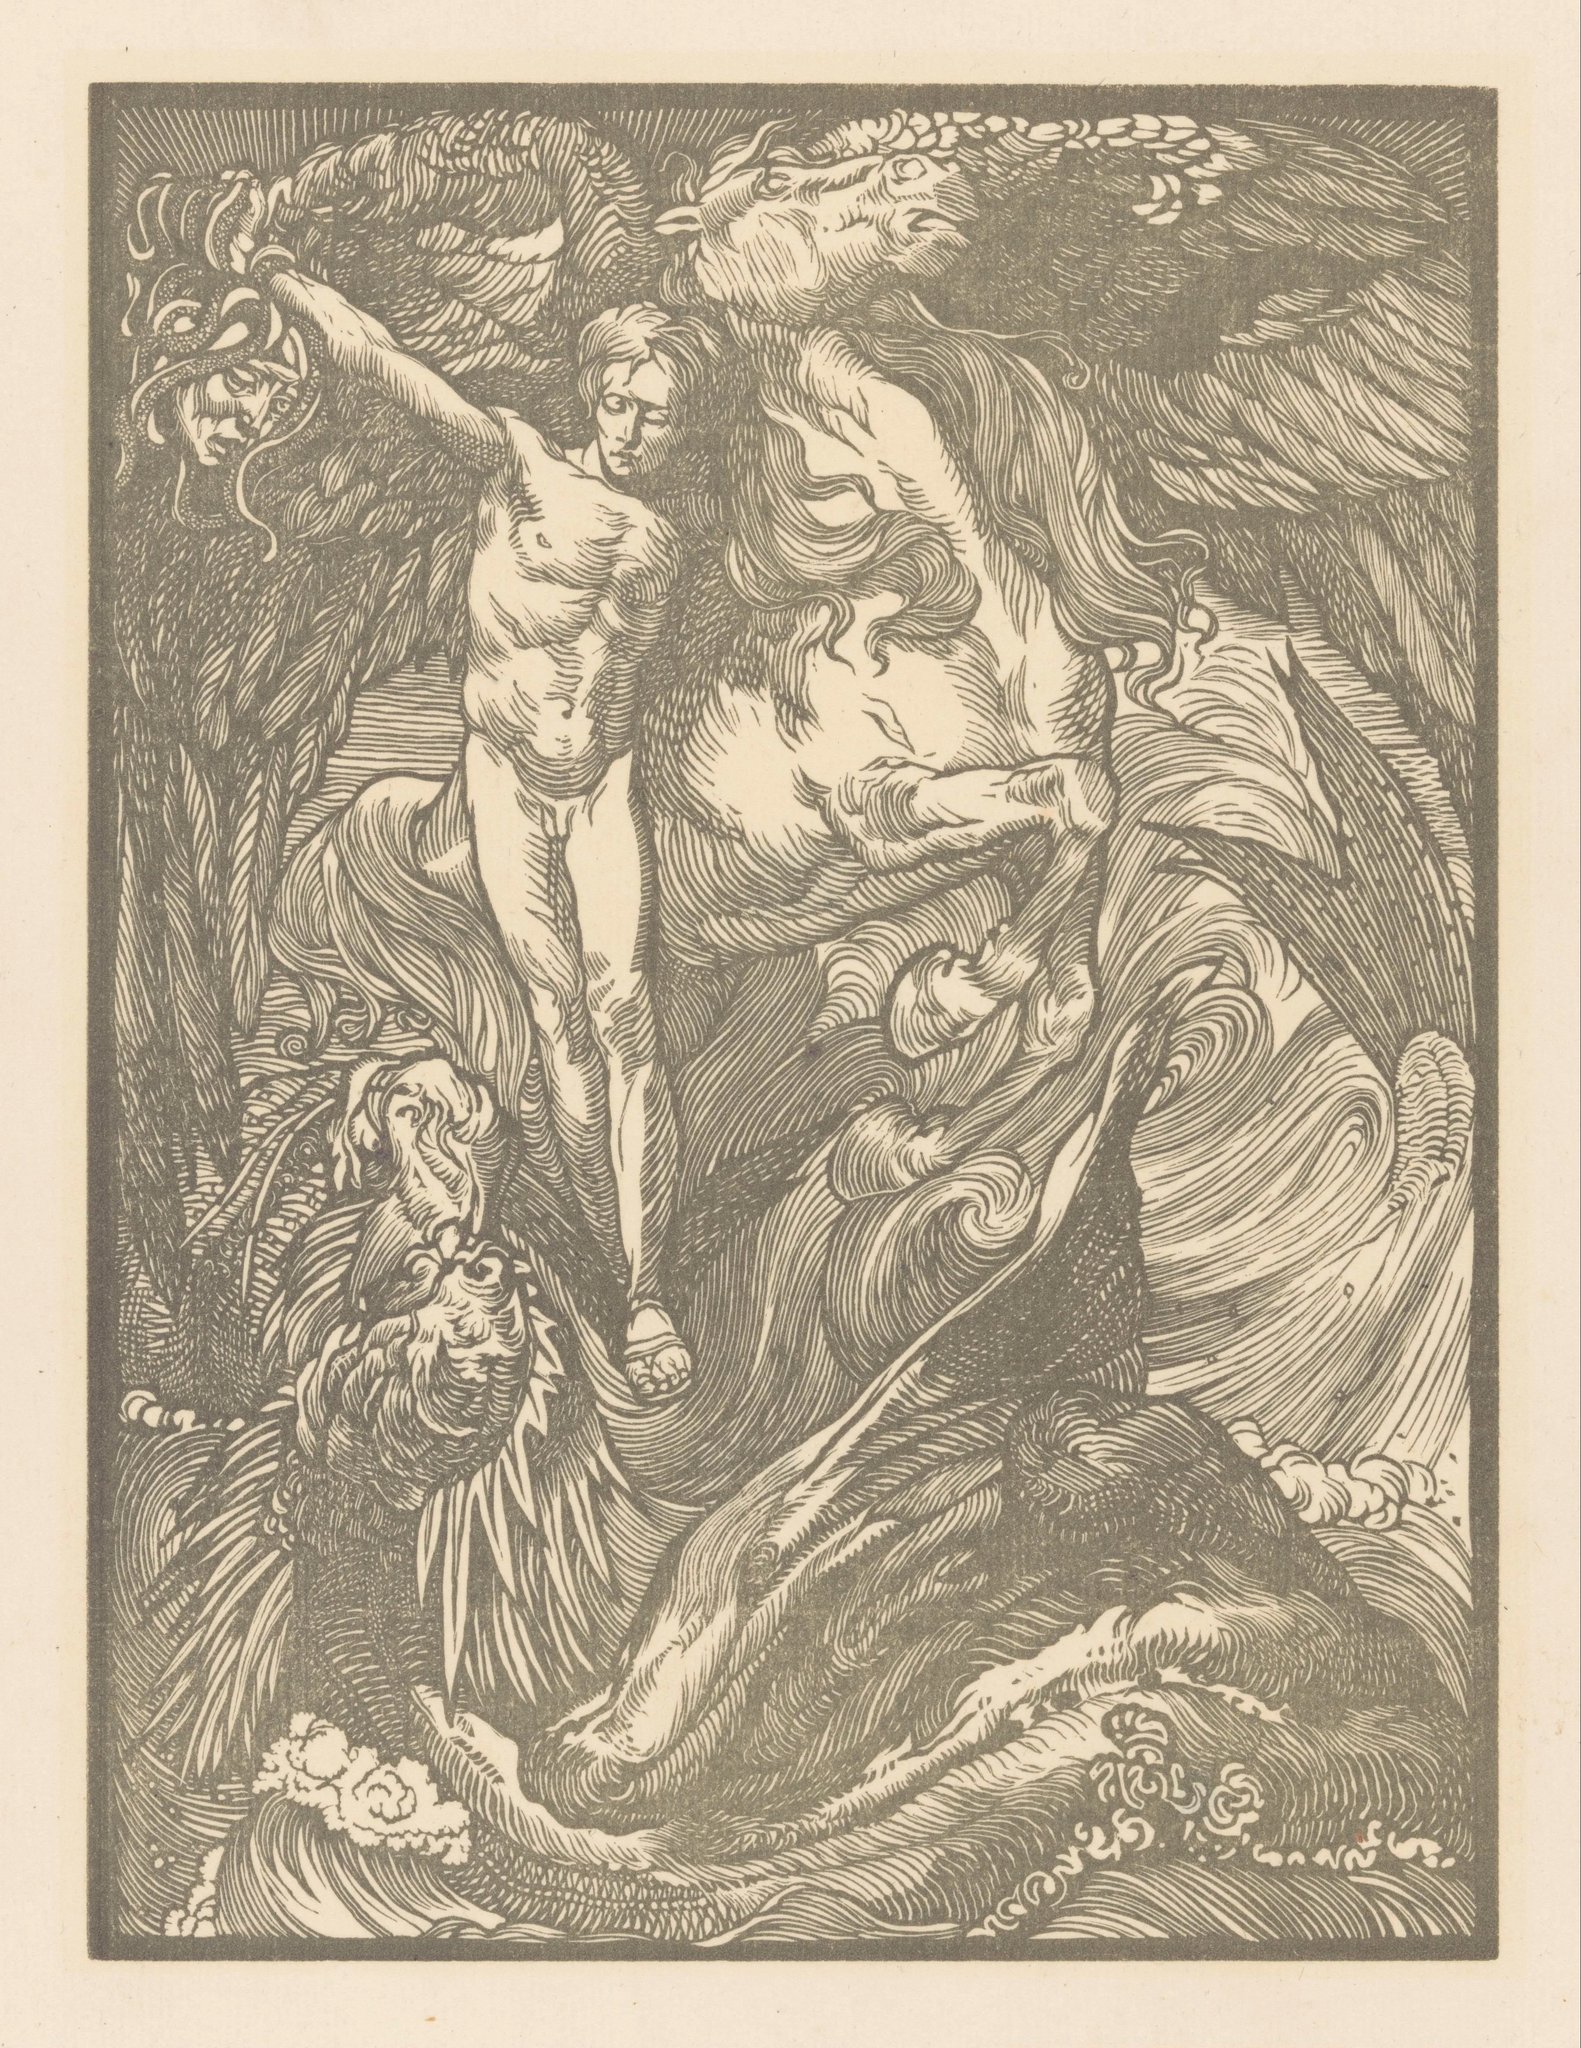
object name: print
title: Perseus en het zeemonster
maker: johannes josephus aarts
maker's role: draughtsman, print maker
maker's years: 1871-1934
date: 1881-1934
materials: paper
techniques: woodcut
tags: pegasus, the winged horse, (story of) perseus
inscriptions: collector's mark: Lugt 2760, collector's mark: Lugt 2166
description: Perseus zweeft hangend aan het gevleugelde paard Pegasus door de lucht. Hij houdt het afgehakte hoofd van Medusa boven het zeemonster waaraan Andromeda is geofferd.